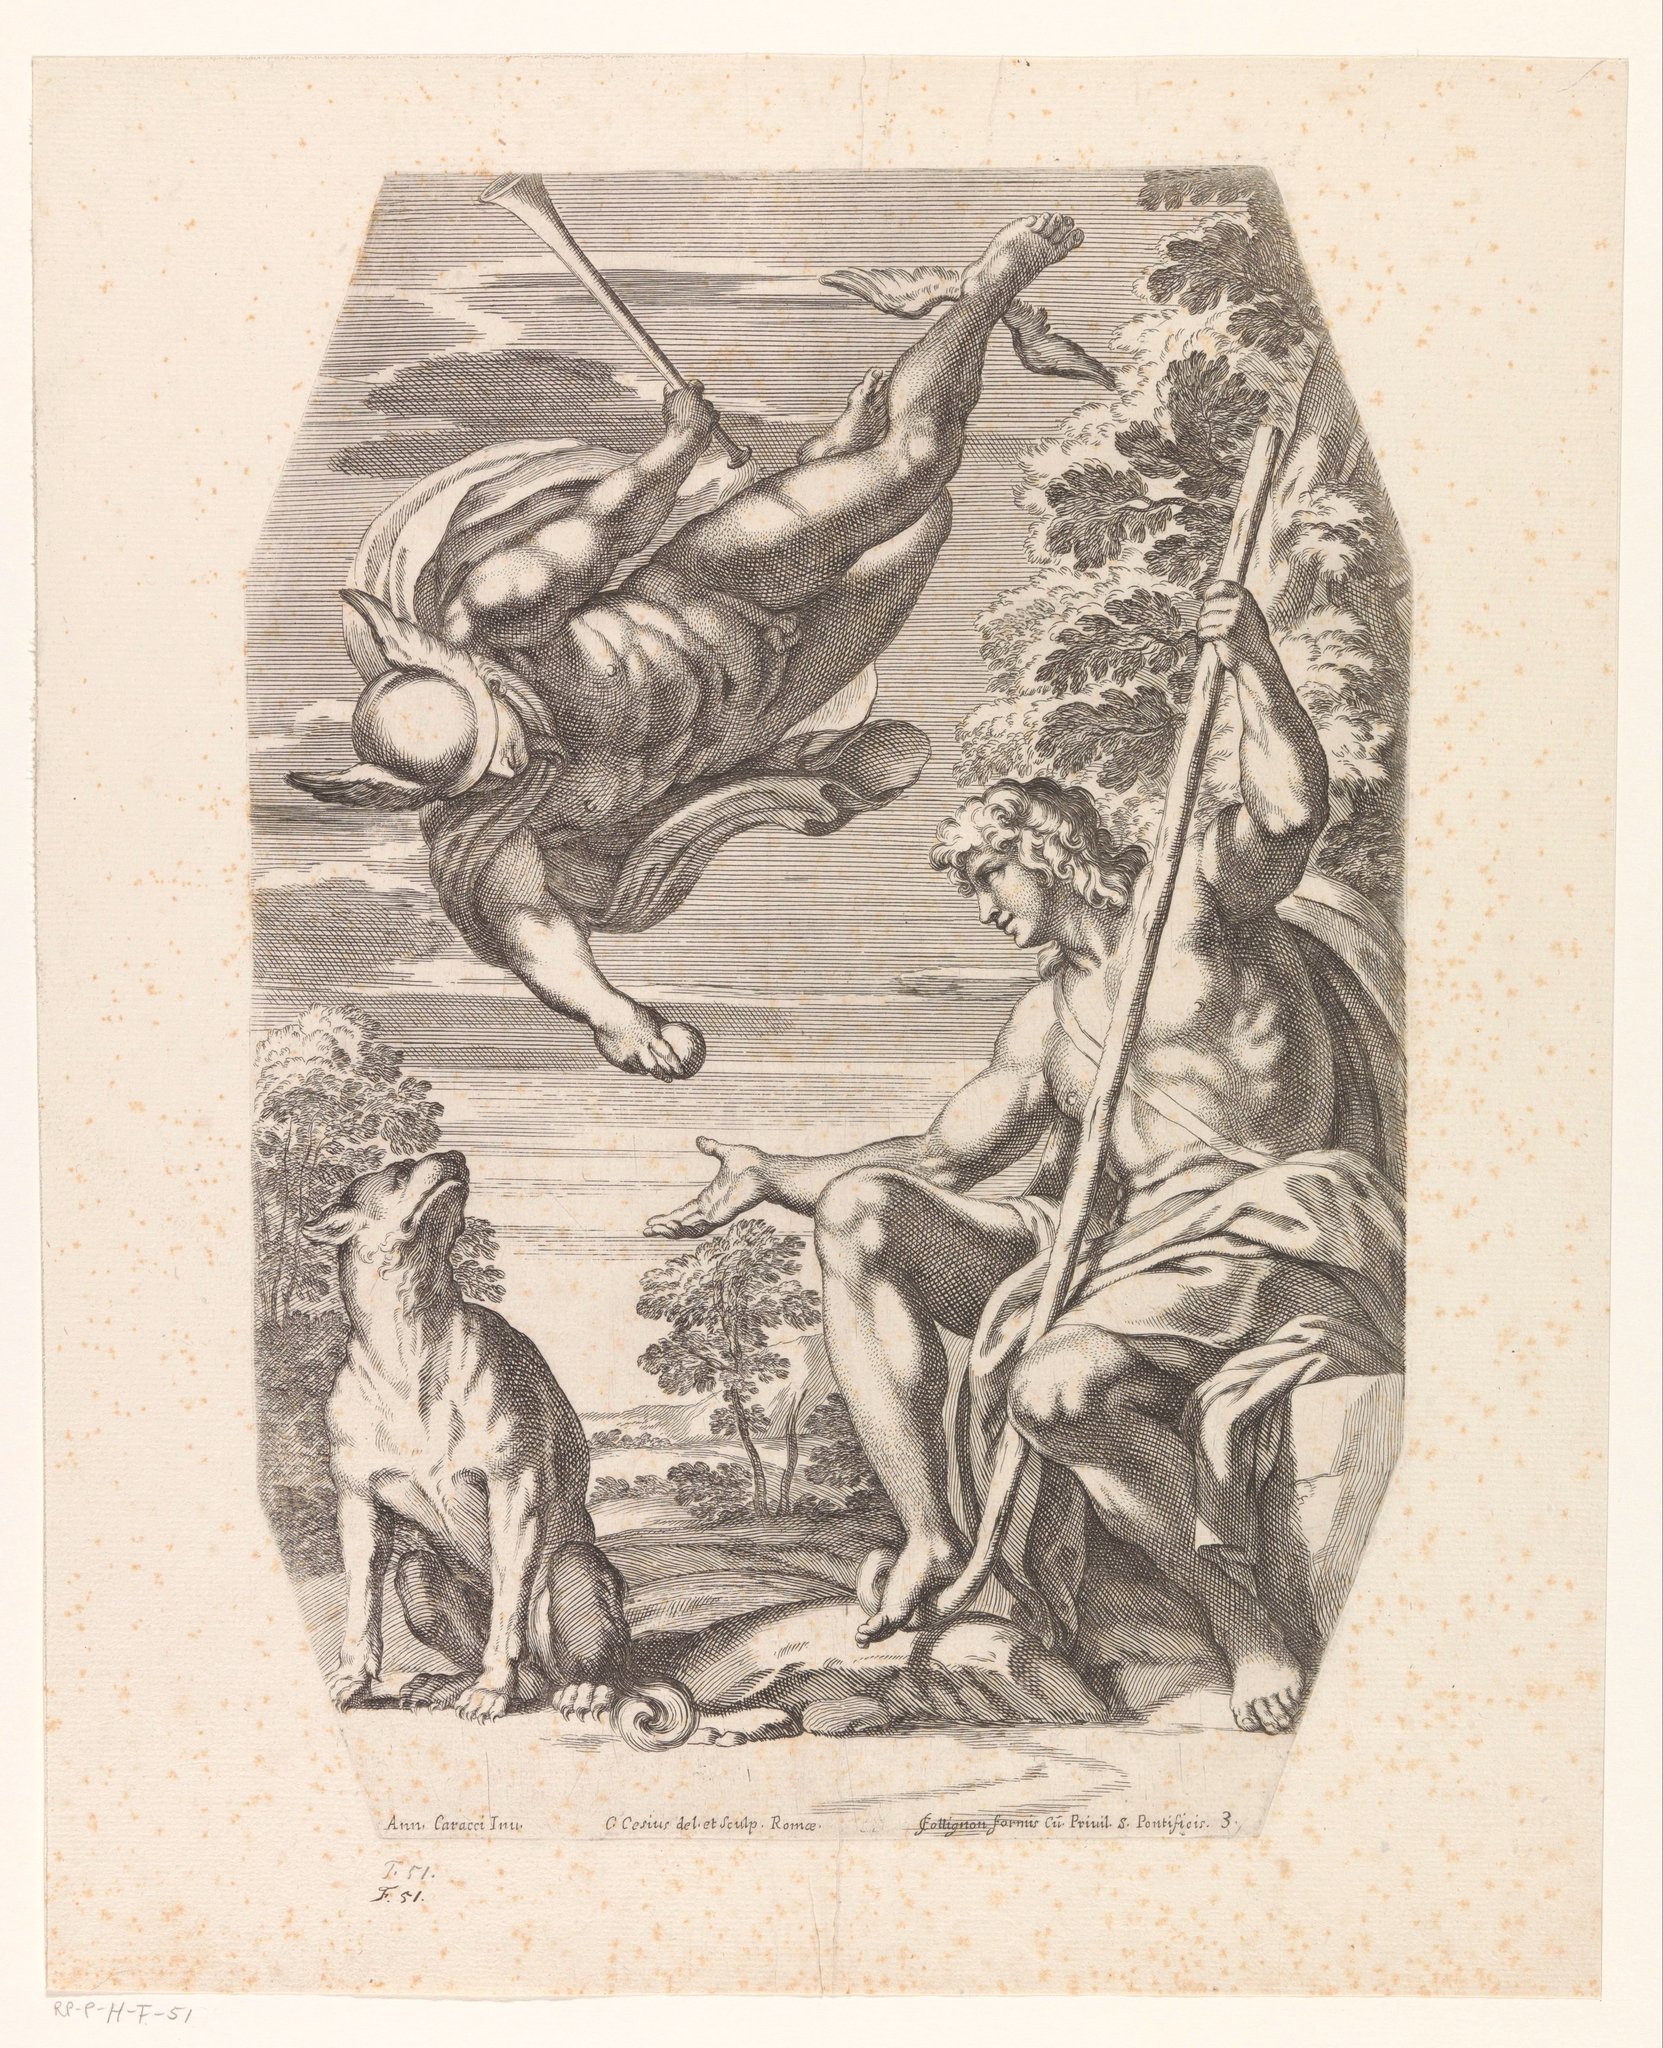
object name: print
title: Schilderingen in Palazzo Farnese te Rome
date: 1656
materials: paper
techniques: etching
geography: rome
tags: mercury brings paris the golden apple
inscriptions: collector's mark: ‘Hinloopen’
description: Prent uit een reeks prenten met nummers van 1 tot en met 29 (sommige prenten hebben hetzelfde nummer), plus titelprent en opdracht, naar schilderingen in Palazzo Farnese te Rome. Deze prent maakte oorspronkelijk deel uit van liber nr. 22 van de Atlas van Rome, uit de collectie Hinloopen. In dit album waren een aantal prentreeksen naar bekende zeventiende eeuwse frescoseries bijeengebonden. In 1709 heeft Schijnvoet op last van de burgemeesters van Amsterdam de collectie herordend. De prenten uit liber 22 kwamen terrecht in Schijnvoet boek nr. 10. De laatst gedateerde reeks in het album is gedateerd 1691. Het album moet dus na deze datum gebonden zijn. De band is in de Rijksakademietijd uit elkaar gehaald. De marges van de prenten zijn bij het opbergen in het Rijksprentenkabinet vaak drastisch afgesneden. Van een aantal series waren de prenten teruggeslagen om in het album te passen. (Zie: Waals, Jan van der. De prentschat van Michiel Hinloopen. 's-Gravenhage: SDU uitgeverij, 1988, pp. 173-174.)